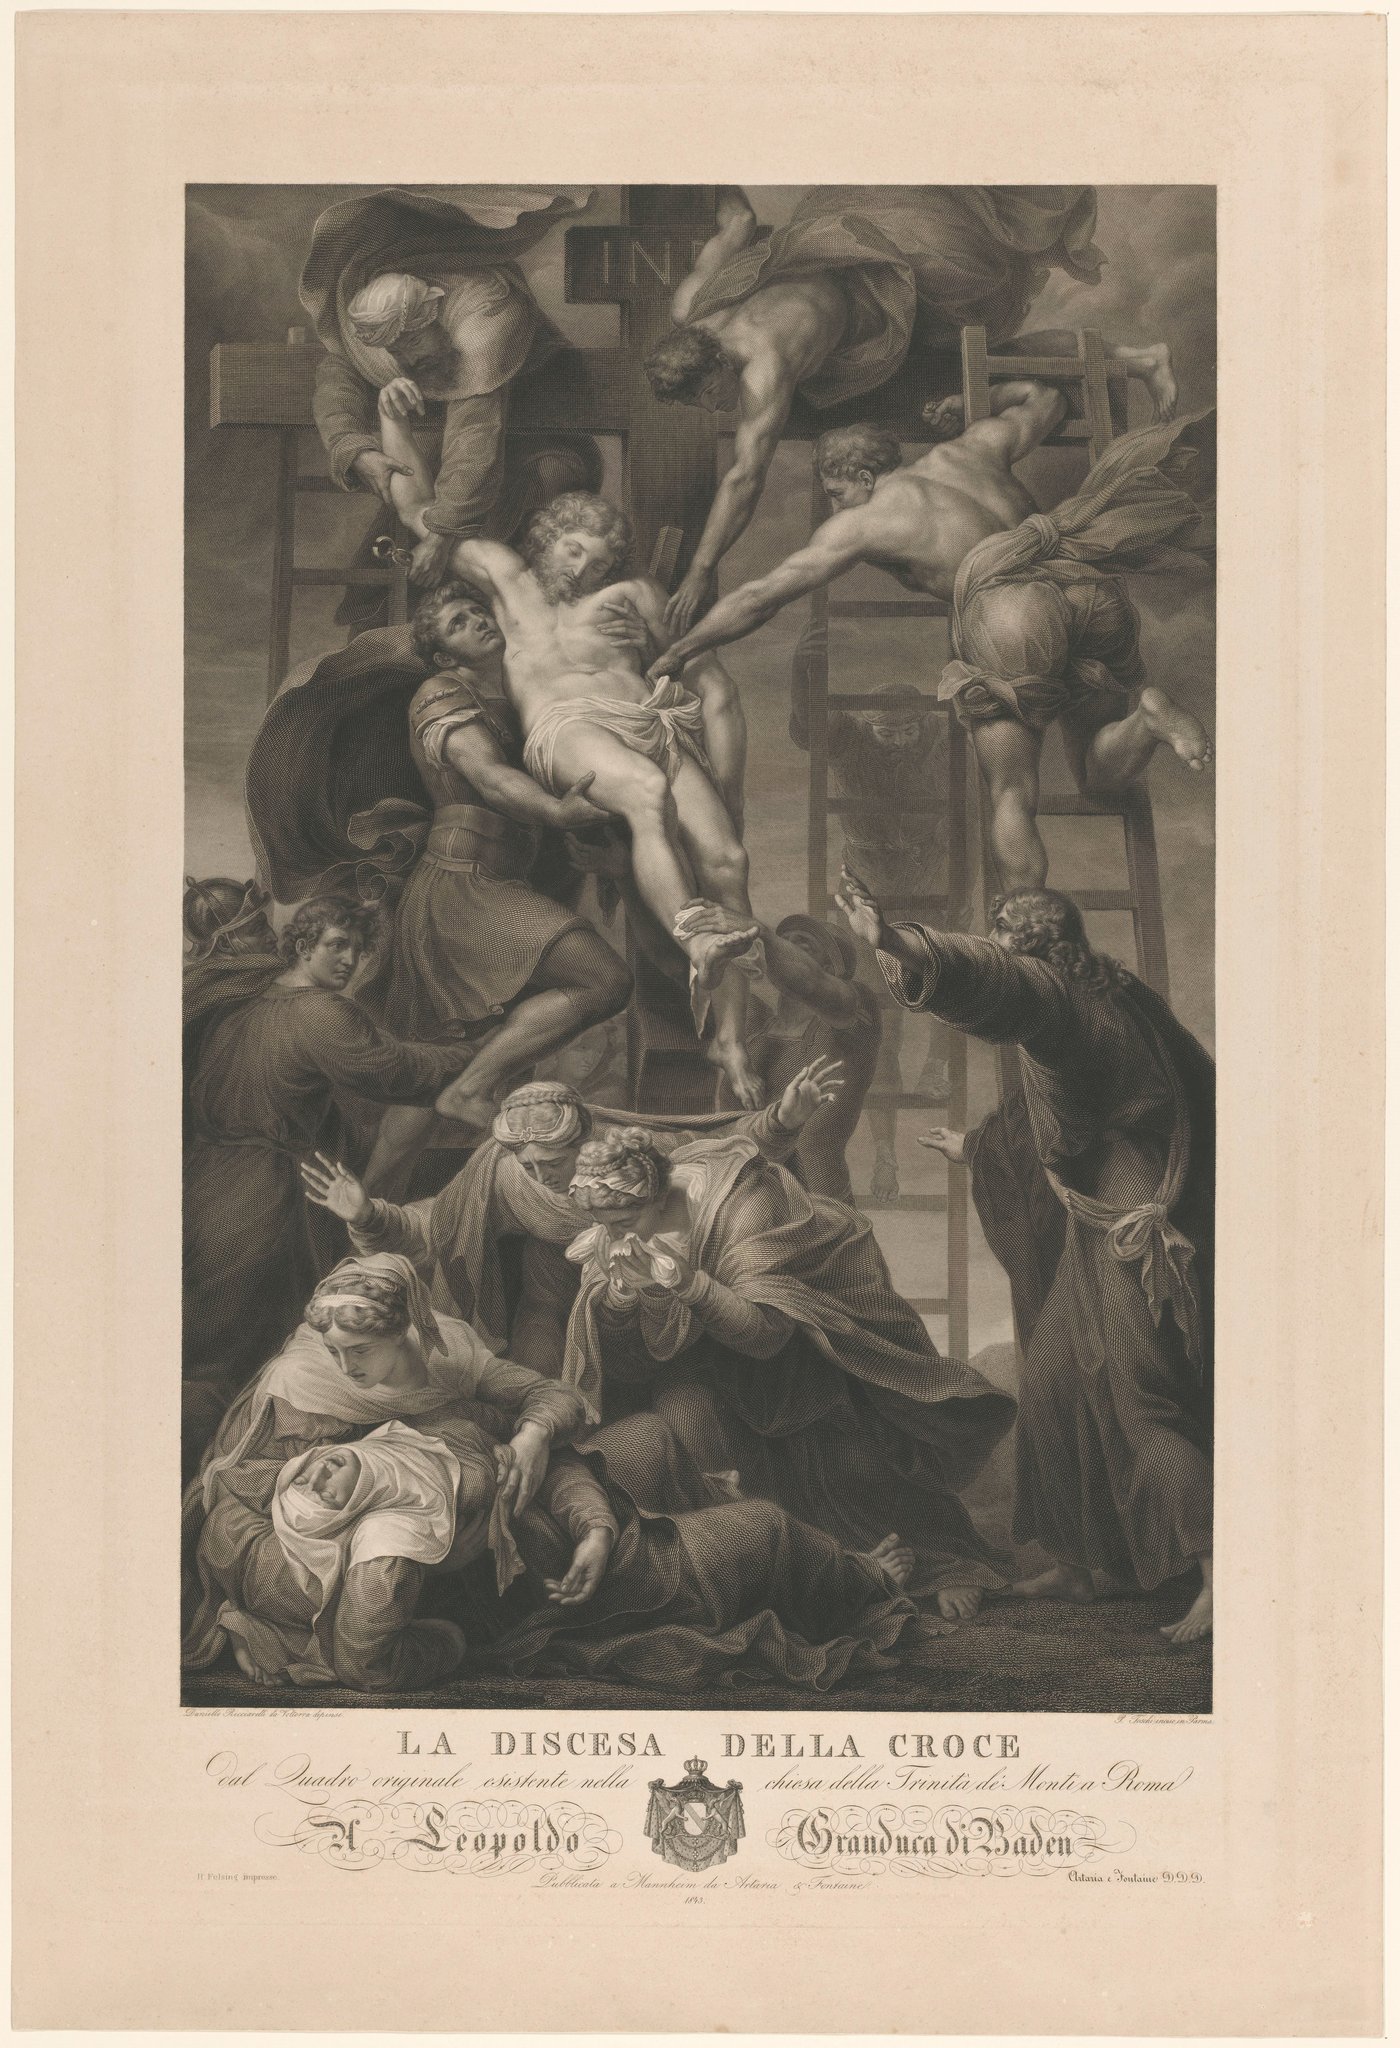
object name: print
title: La discesa della croce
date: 1843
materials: paper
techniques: engraving, etching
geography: italy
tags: descent from the cross: christ is taken down from the cross, usually by nicodemus and joseph of arimathaea who are standing on the ladders (both arms of christ detached)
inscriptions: collector's mark: Lugt 12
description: Het lichaam van Christus wordt door een groep mannen op ladders van het kruis gehaald. Aan de voet van het kruis treuren de Maria's. Titel, opdracht en wapen in ondermarge.